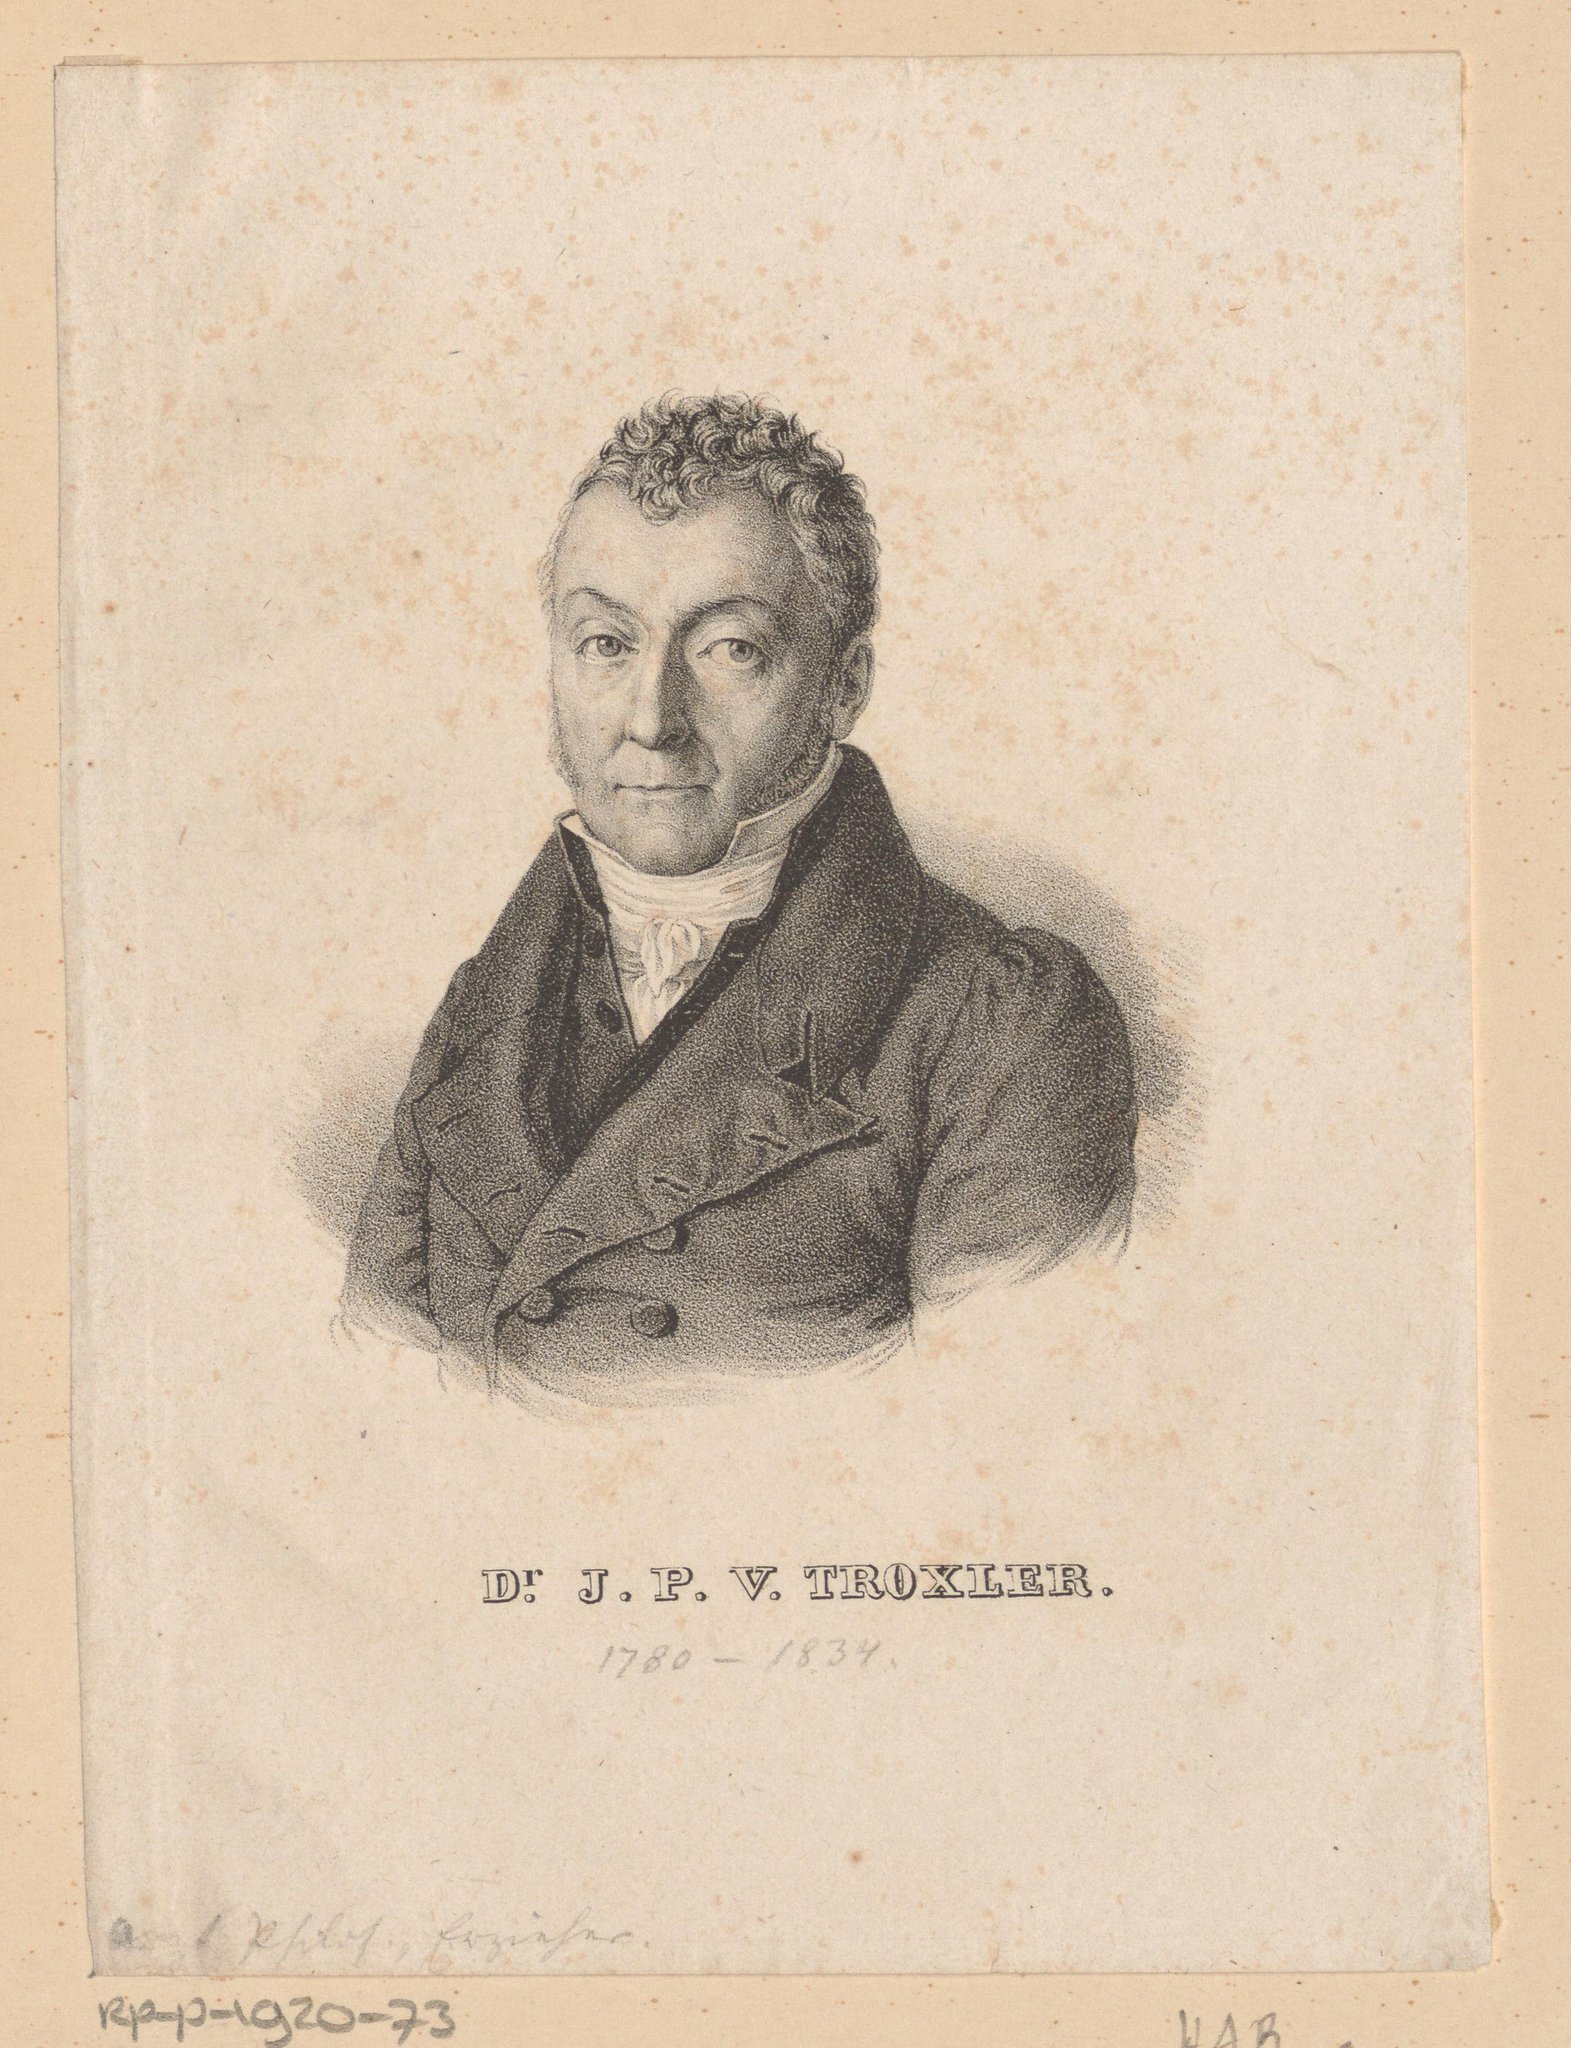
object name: print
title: Portret van Ignaz Paul Vitalis Troxler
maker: Anonymous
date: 1820-1900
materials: paper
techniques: lithograph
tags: switzerland, scholar, philosopher, historical persons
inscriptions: collector's mark: Lugt 2228